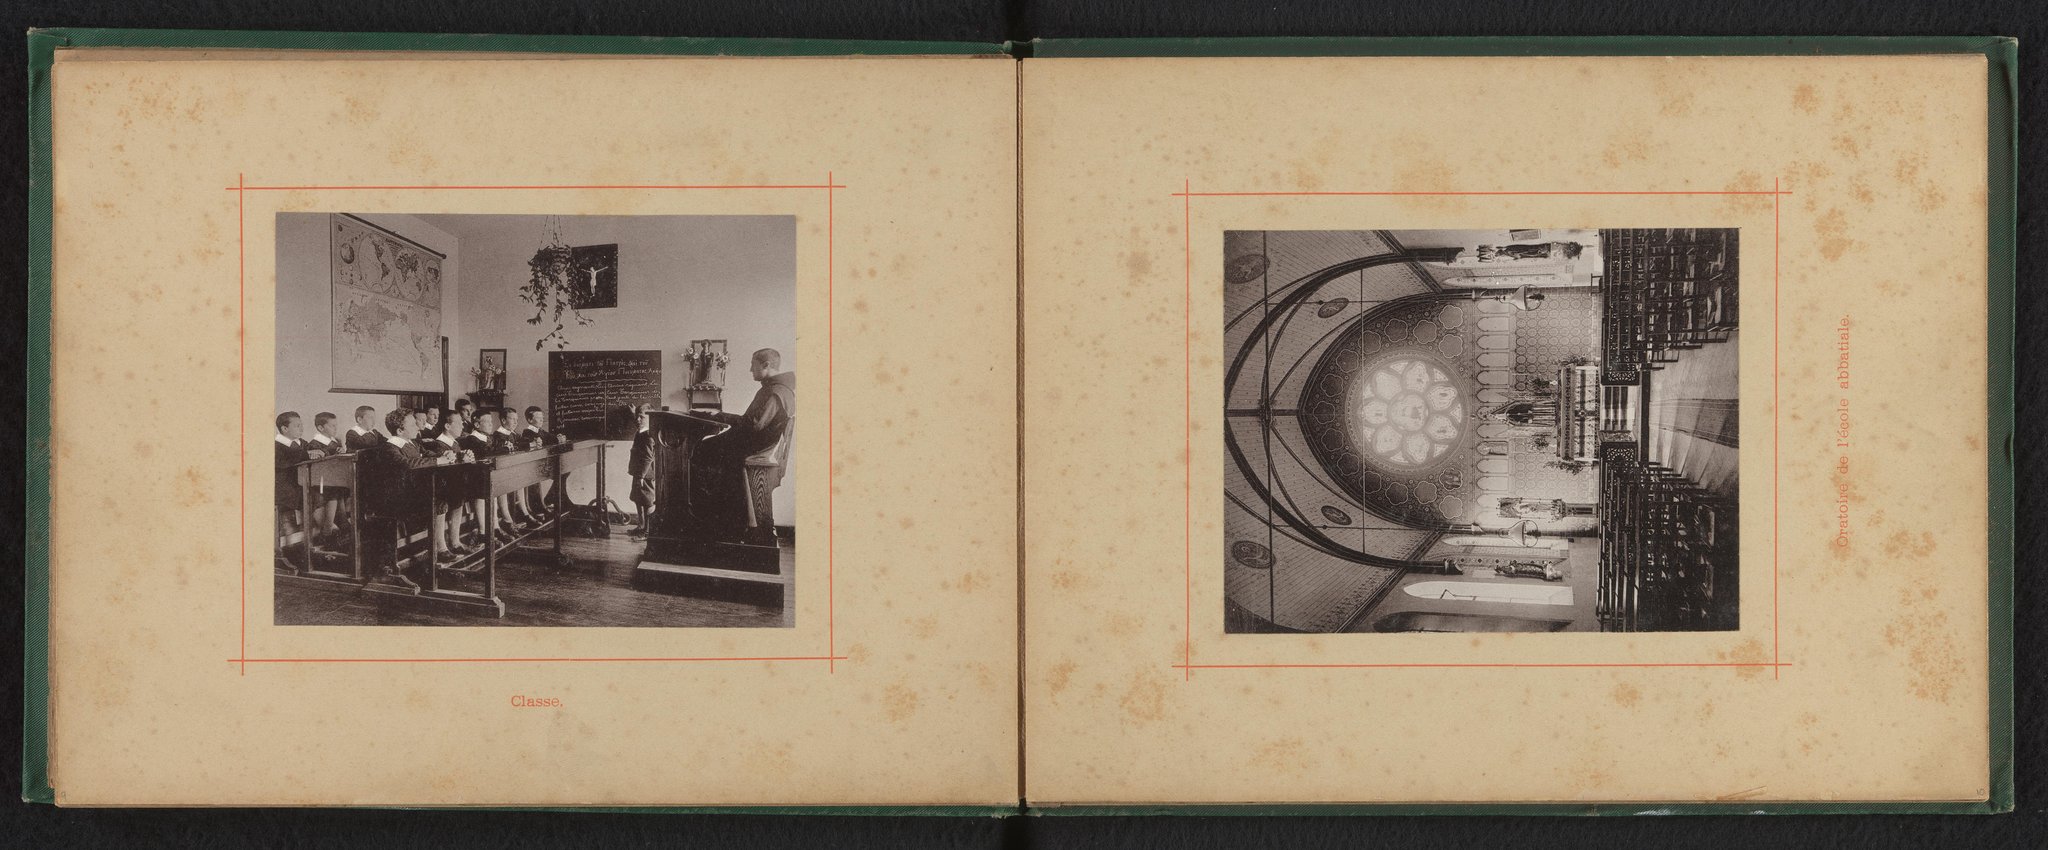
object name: photomechanical print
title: Oratorium van de abdijschool van Maredsous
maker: Anonymous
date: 1900-1905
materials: paper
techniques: photograph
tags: abbey, monastery, convent ~ roman catholic church, communal rooms